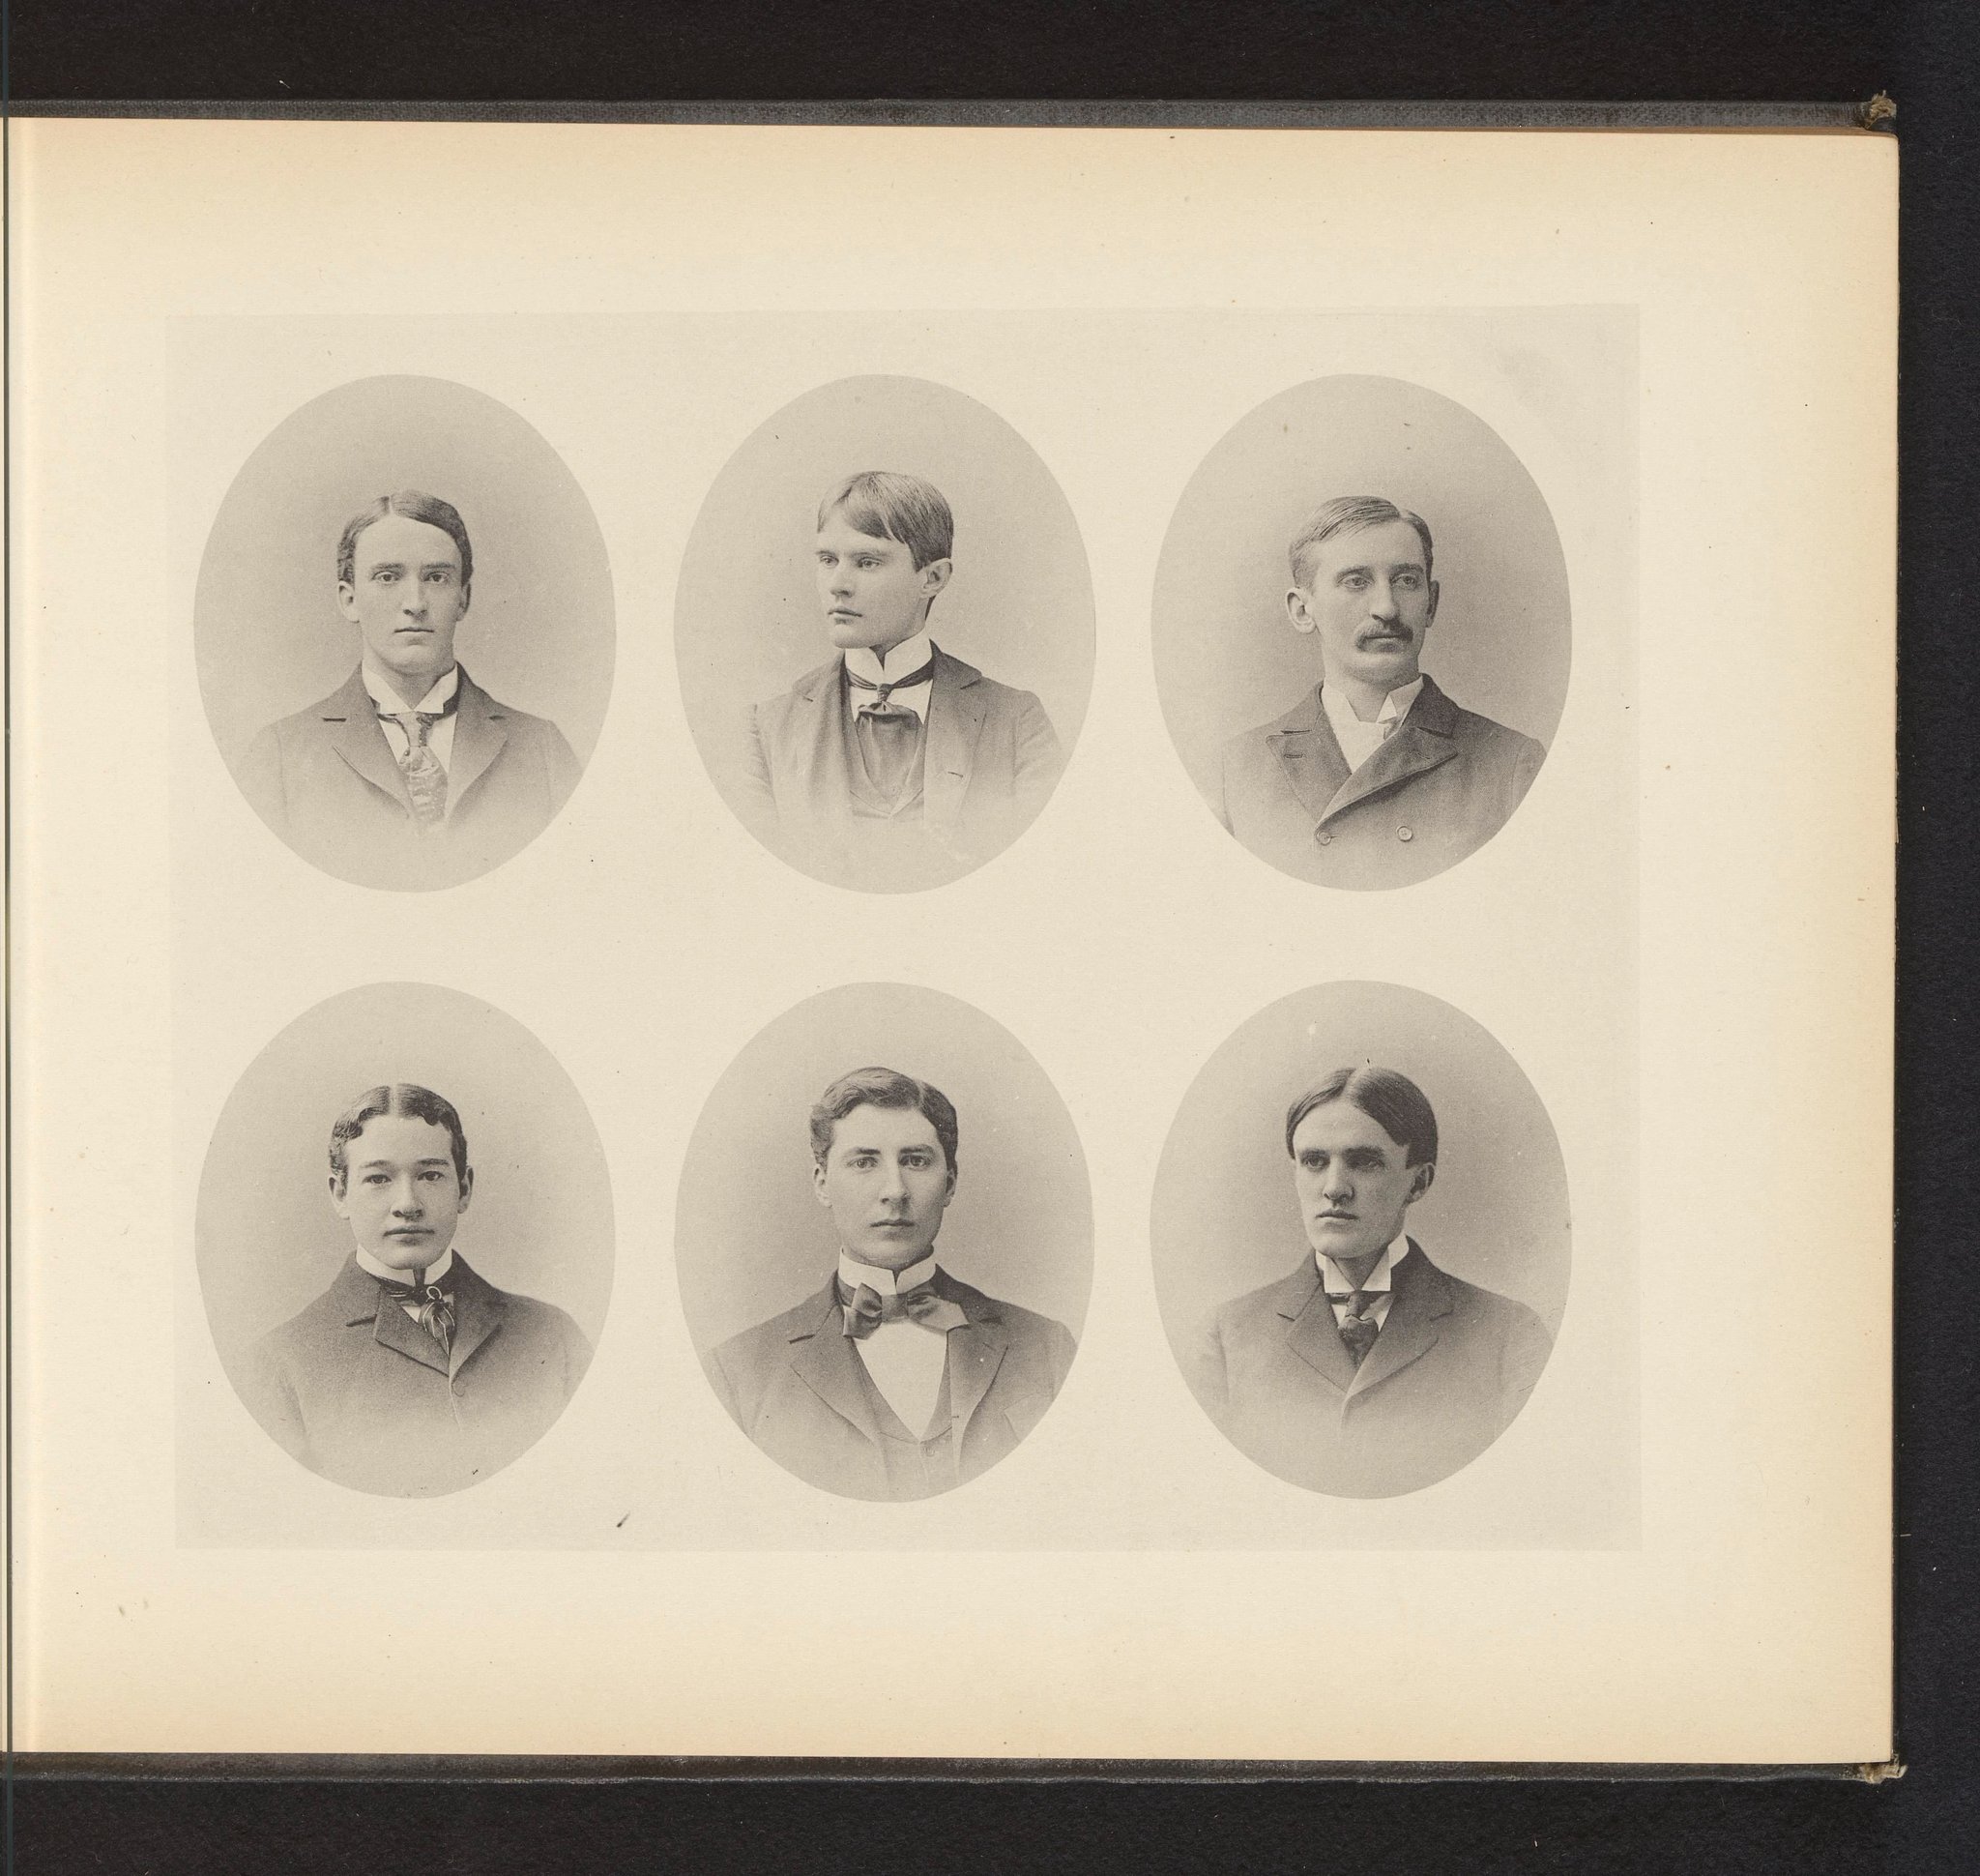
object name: page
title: Zes portretten van afgestudeerde studenten van Yale University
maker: Anonymous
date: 1895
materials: paper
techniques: photograph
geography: new york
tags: student